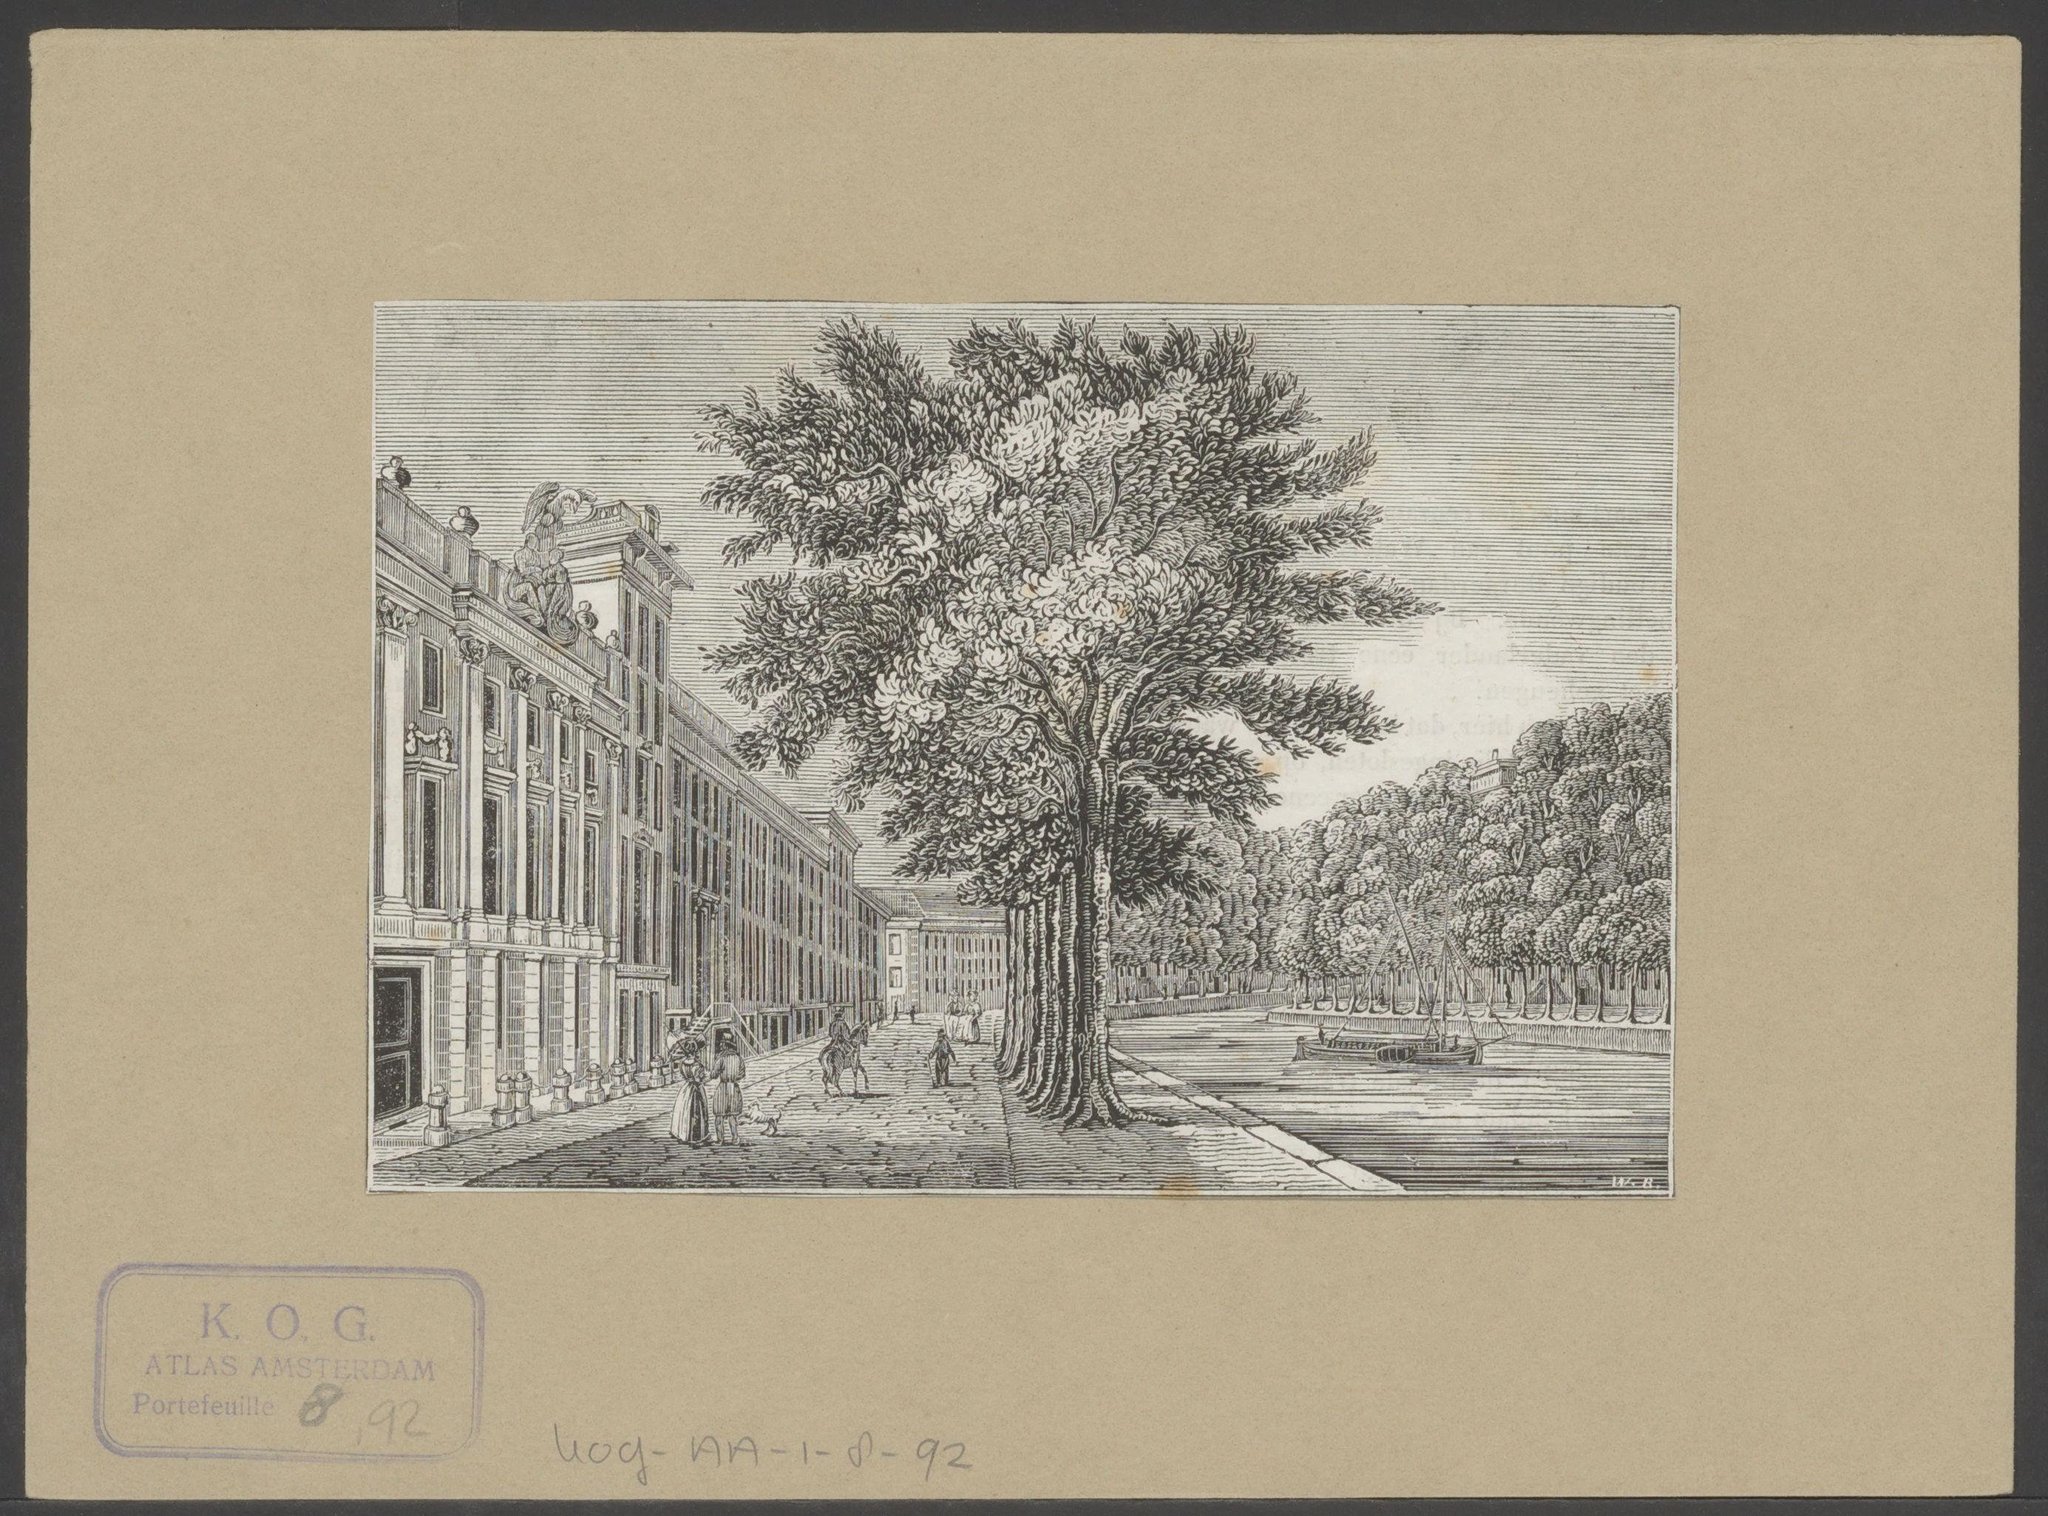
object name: print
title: Gezicht op de Herengracht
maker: Anonymous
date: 1800-1899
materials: paper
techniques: letterpress printing, engraving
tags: city-view in general; 'veduta', canal, bridge in city across river, canal, etc., street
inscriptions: collector's mark: ‘8,92’ Lugt 1641b, signature: ‘W.B.’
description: Onderwerpsrubriek binnen de Atlas Amsterdam: Haarlemmerplein, Halvemaansteeg, Handboogstraat, Handelskade, Haringpakkerij, Hartenstraat, Hasseltsteeg (Dirk van), Heerengracht.